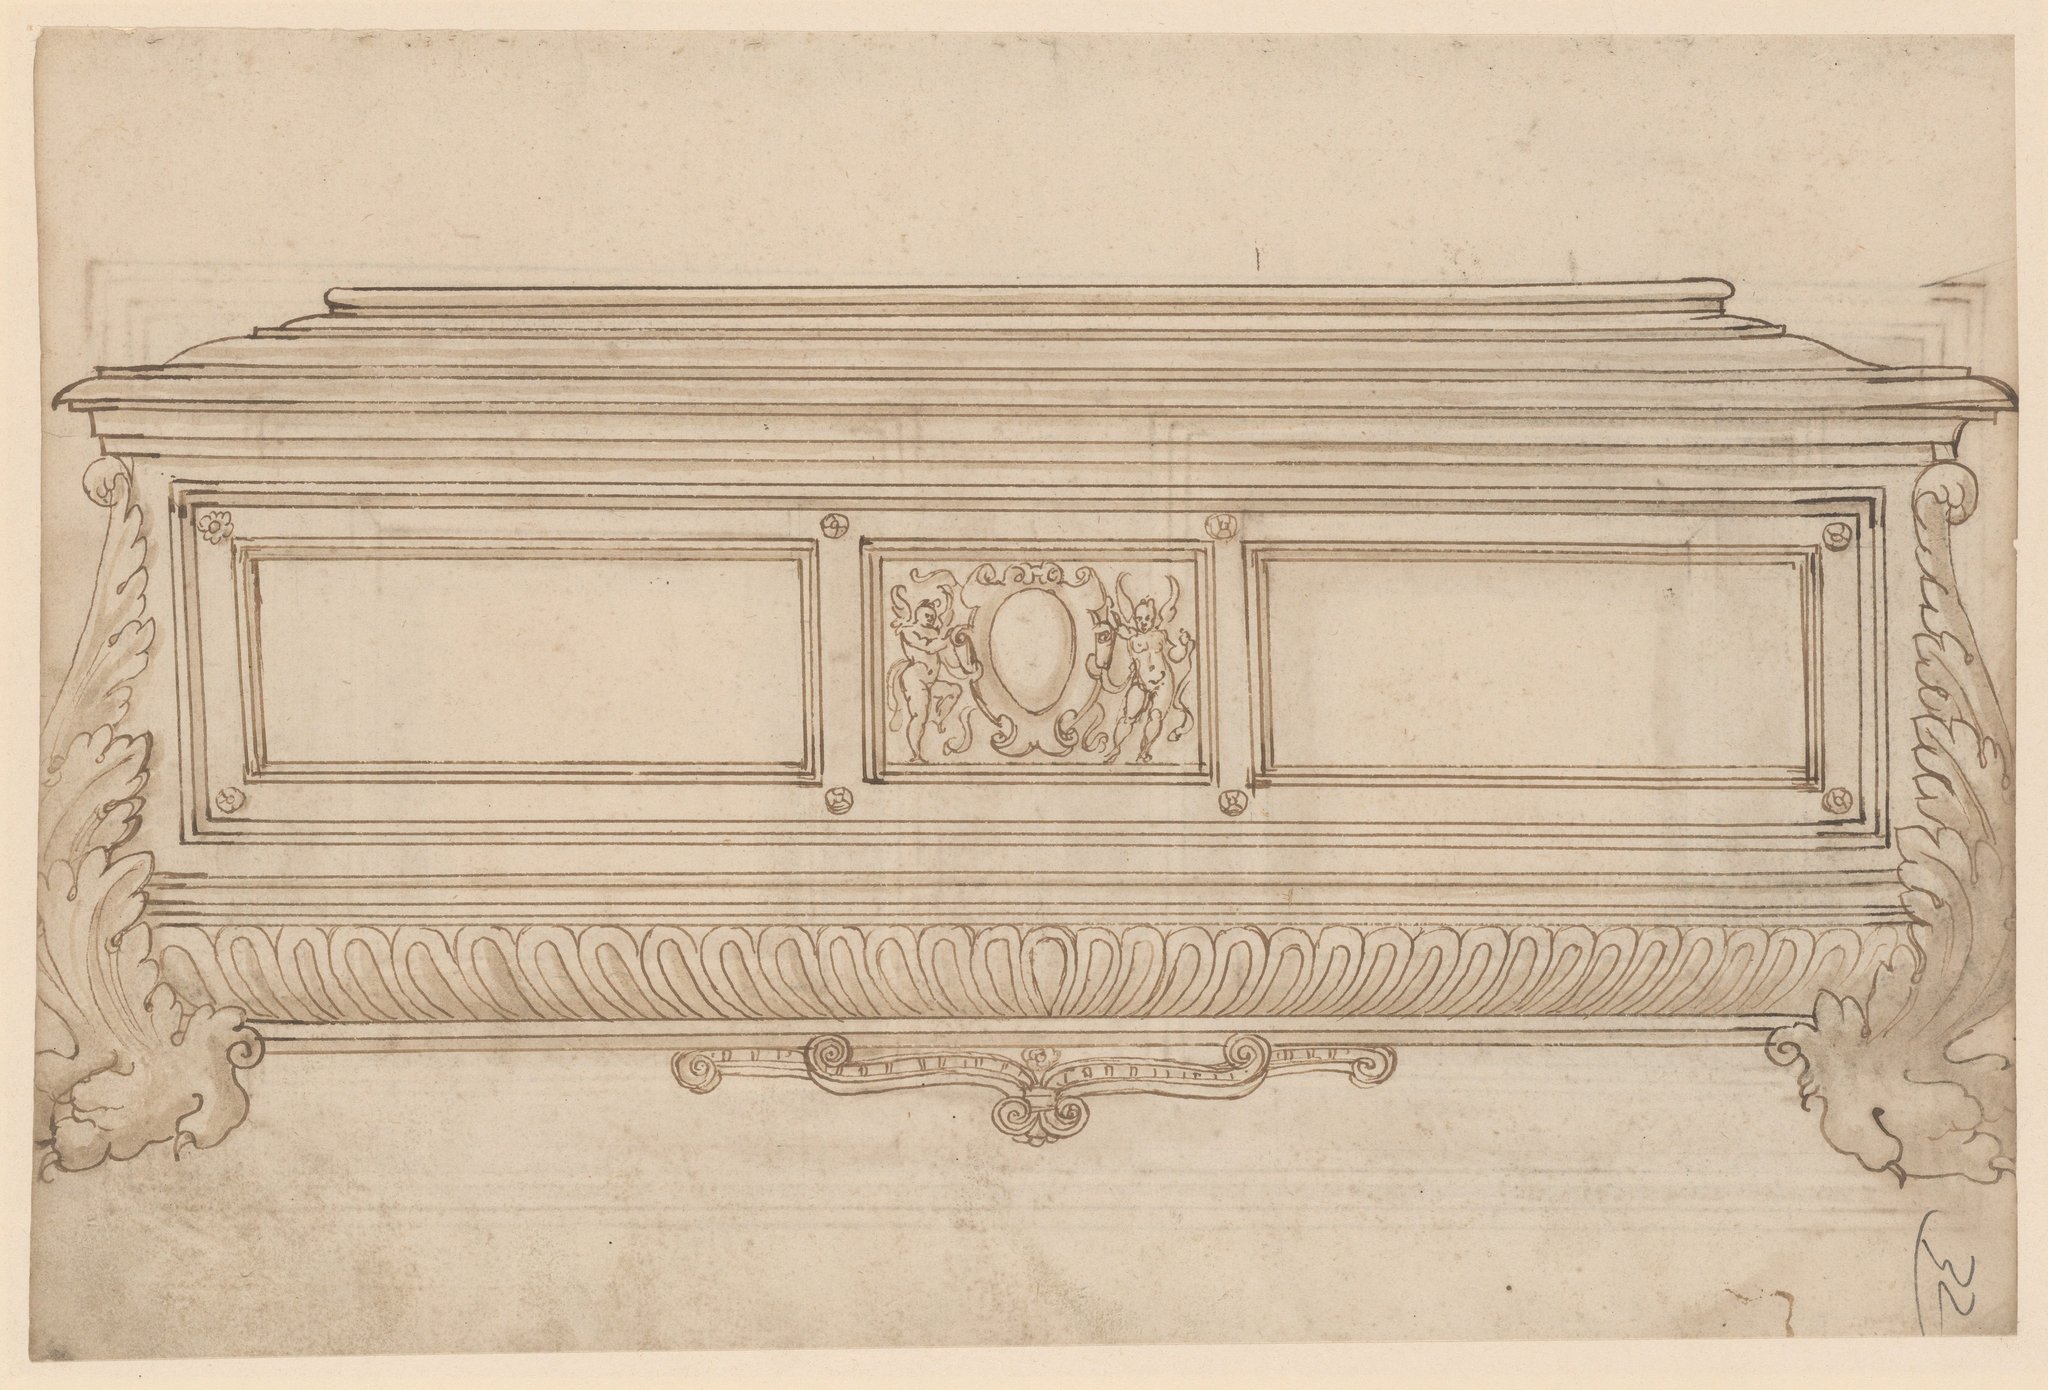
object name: drawing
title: Design for a Cassone. Verso, Design for a Cabinet Door or Cassone Lid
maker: anonymous, italian, 17th century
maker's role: artist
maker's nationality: italian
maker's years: 1600-1700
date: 1600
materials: ink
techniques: pen, wash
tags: chests